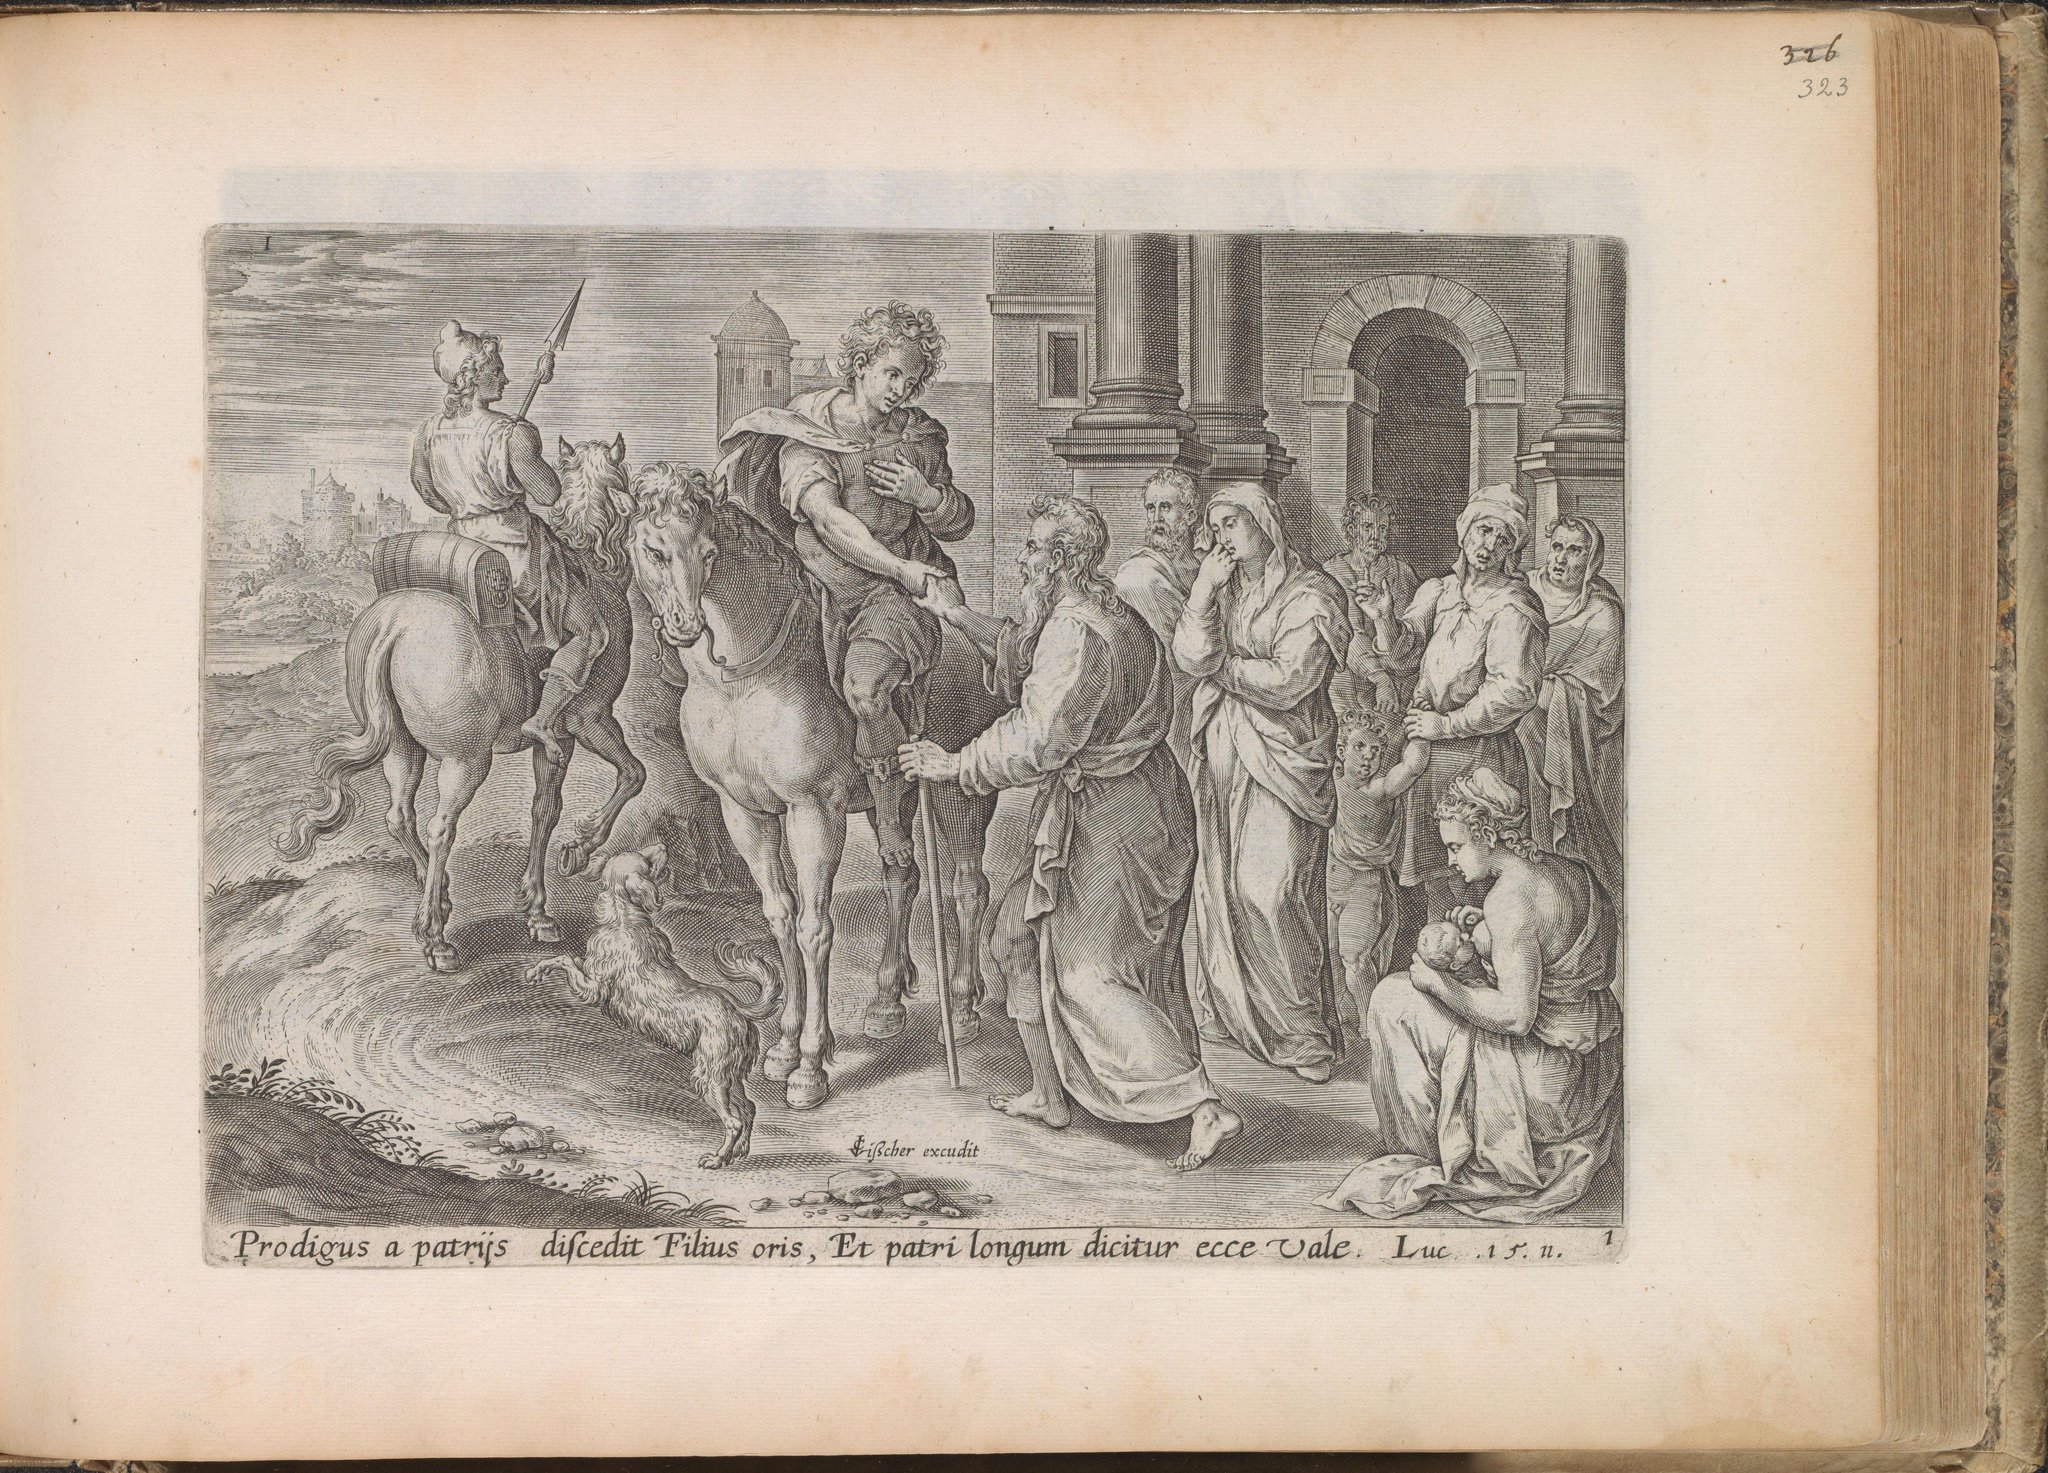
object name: print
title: De verloren zoon neemt afscheid van zijn vader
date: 1585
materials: paper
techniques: engraving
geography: amsterdam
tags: leave-taking and departure of the prodigal son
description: De verloren zoon neemt afscheid van zijn vader. Hij zit te paard en schudt zijn vader de hand. Rechts de familie voor het huis. Onder de voorstelling een verwijzing in het Latijn naar de Bijbeltekst in Luc. 15:11. Deze prent maakt deel uit van een album.